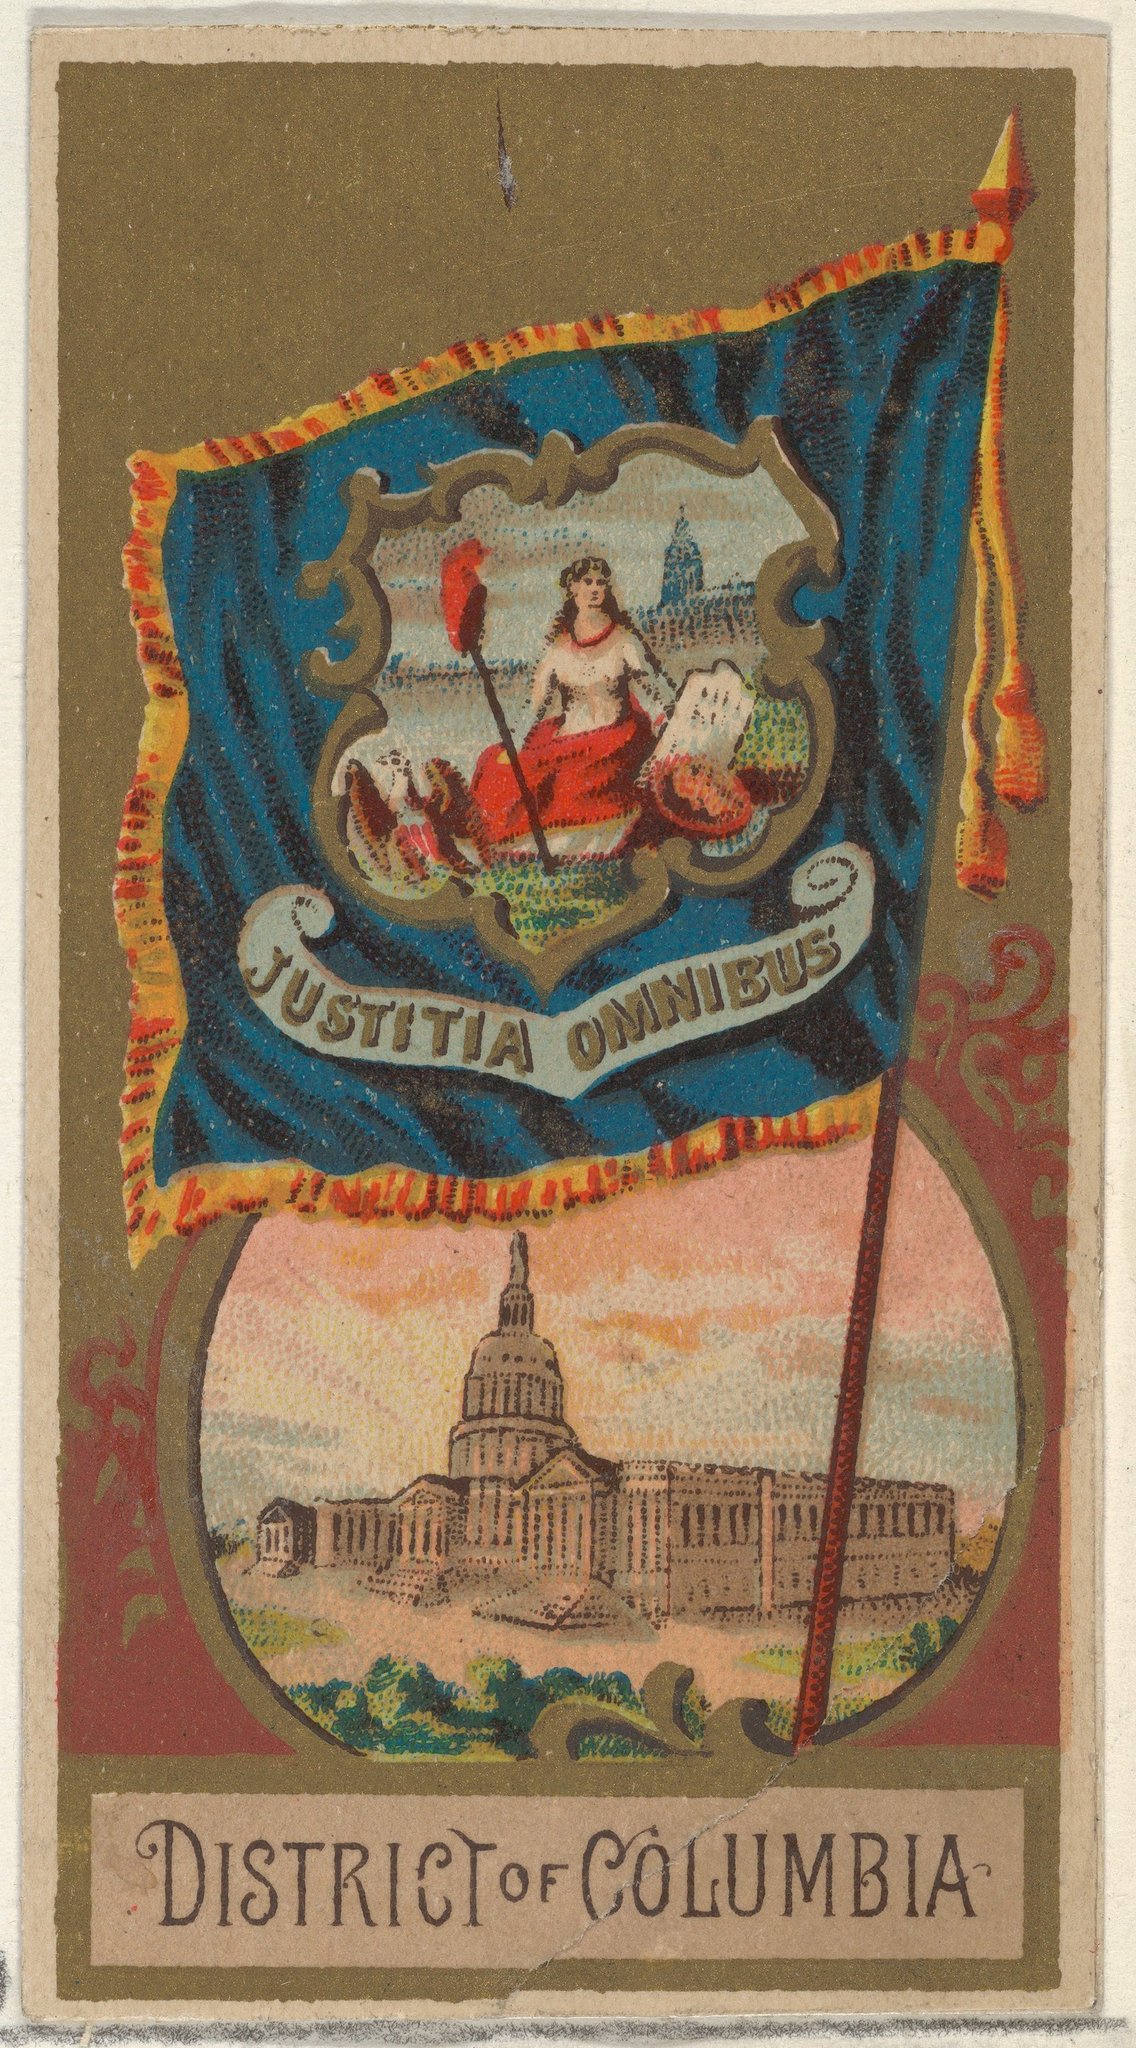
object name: print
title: District of Columbia, from Flags of the States and Territories (N11) for Allen & Ginter Cigarettes Brands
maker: allen & ginter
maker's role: publisher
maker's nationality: american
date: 1888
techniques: color lithograph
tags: flags